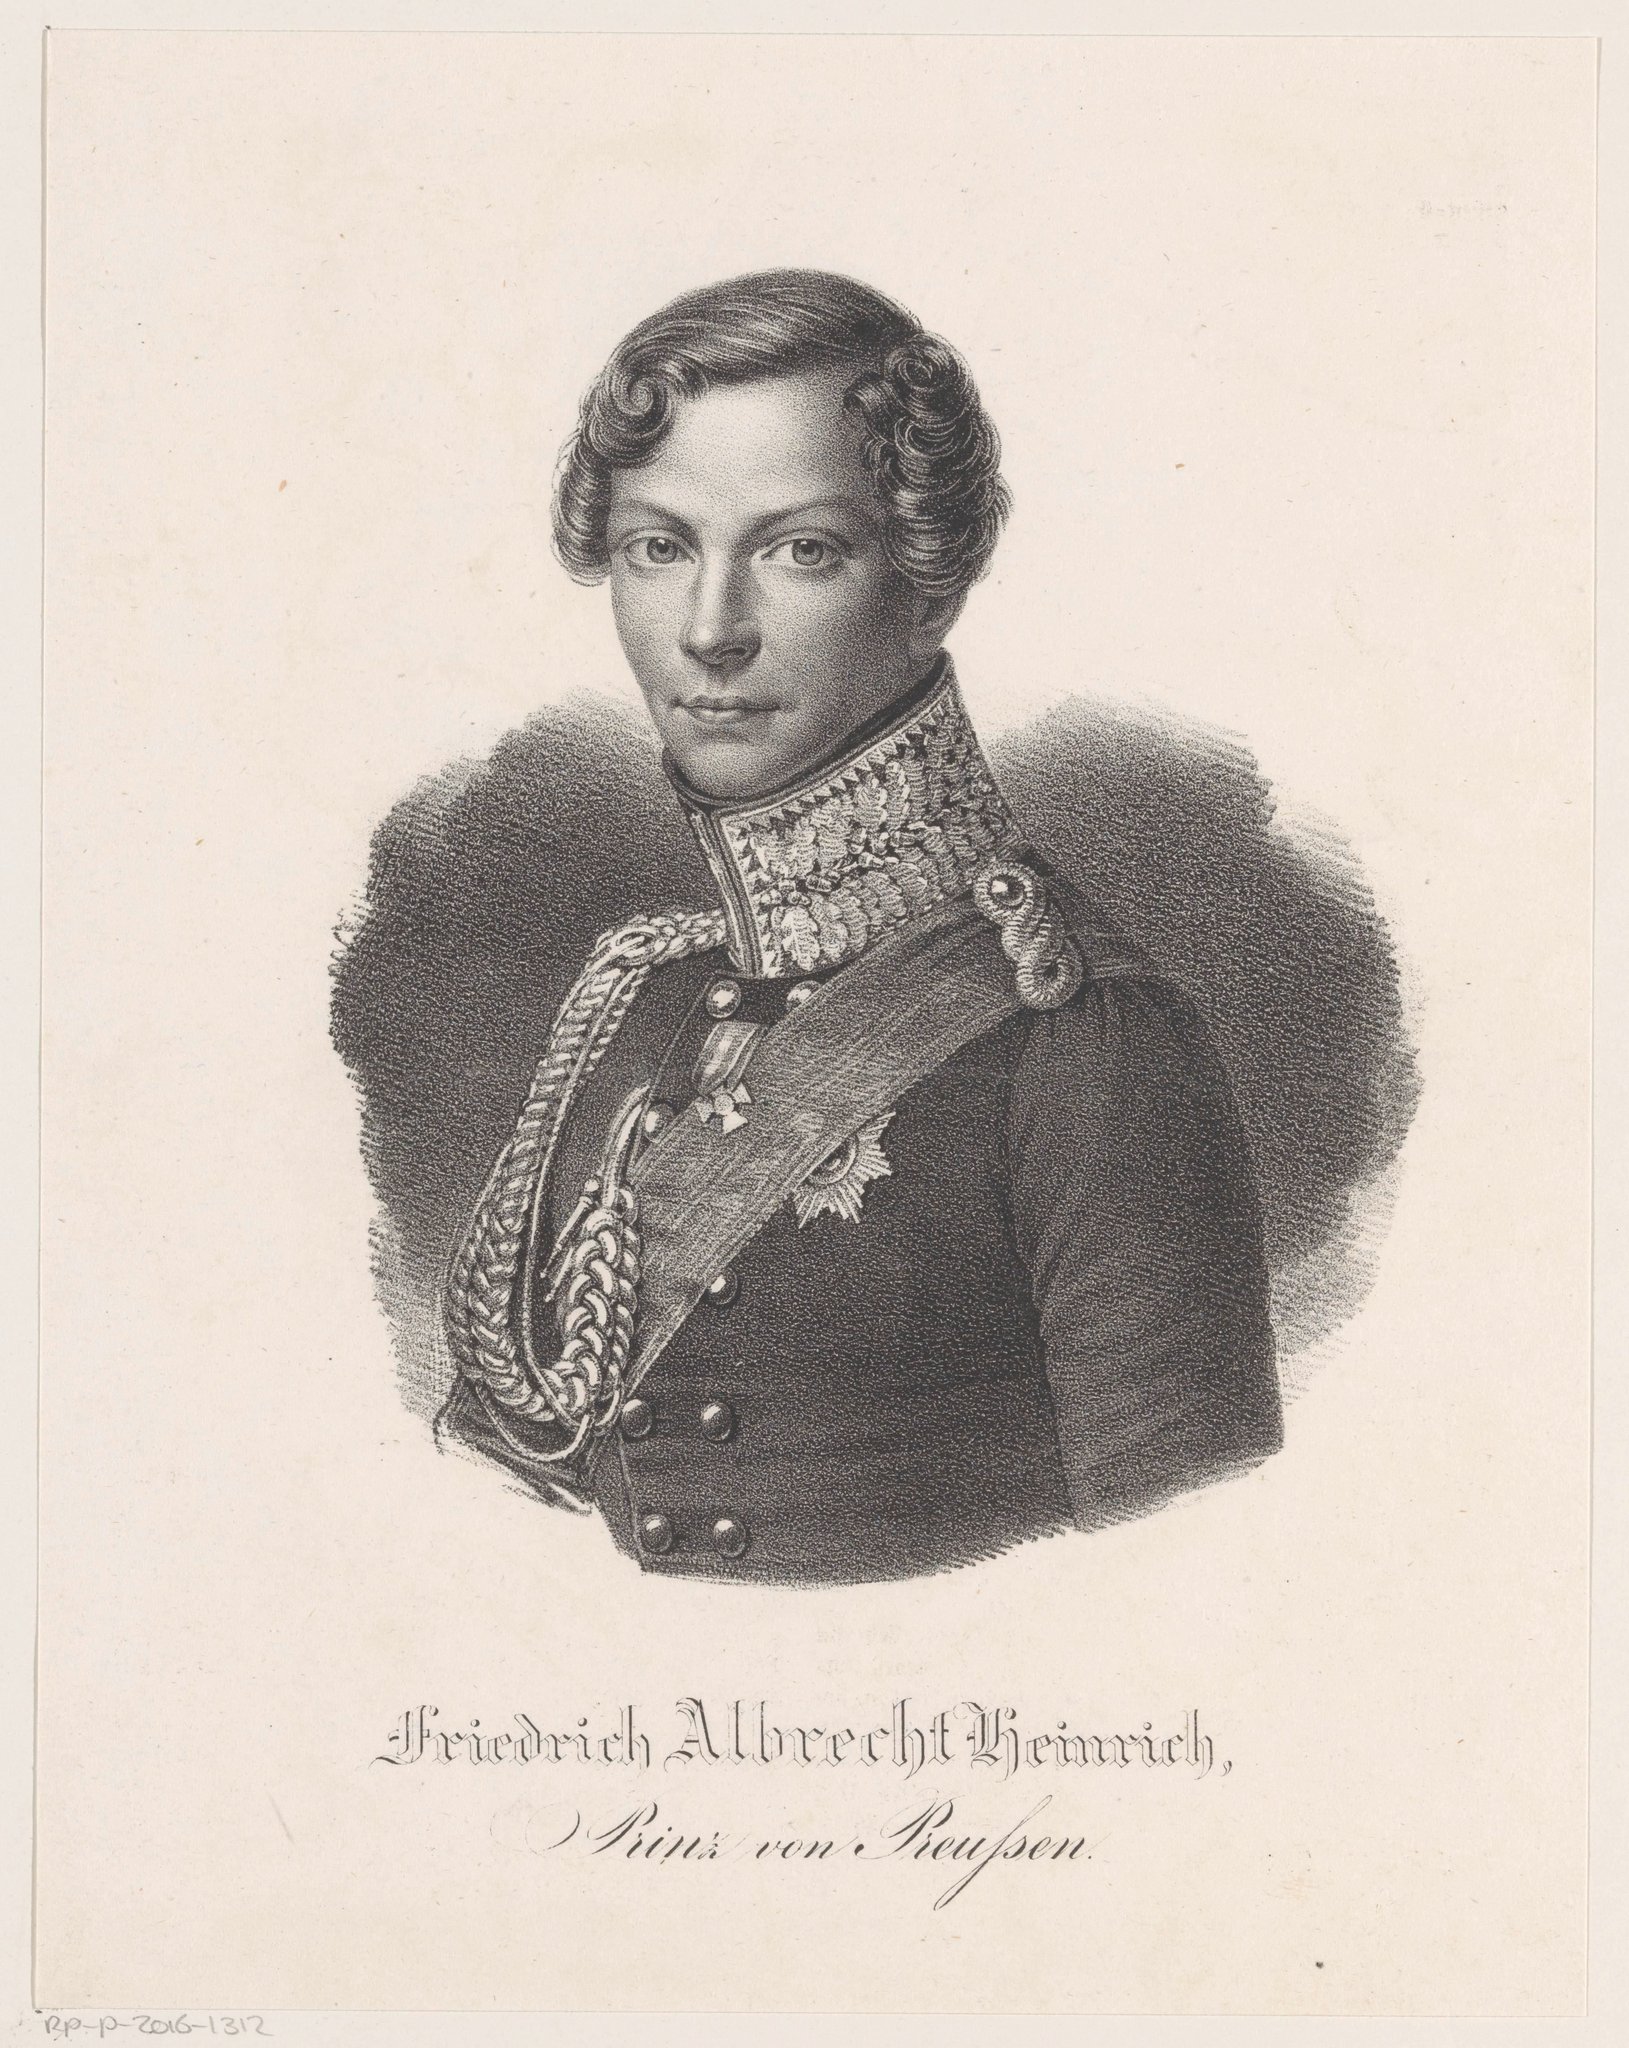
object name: print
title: Portret van Albert Friedrich Heinrich, prins van Pruisen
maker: Anonymous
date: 1825-1899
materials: paper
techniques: lithograph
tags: berlin